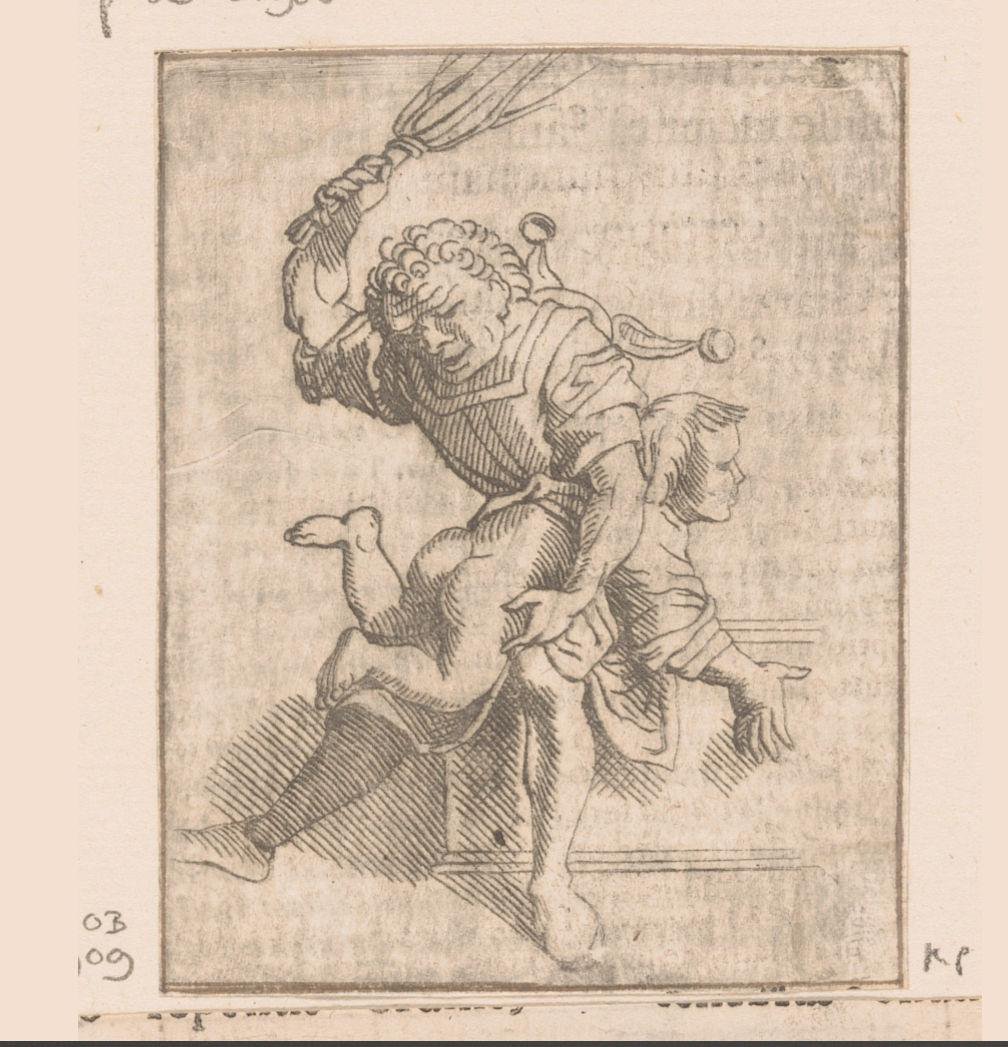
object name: book illustration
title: Onderwijzer straft een leerling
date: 1516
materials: paper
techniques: etching, letterpress printing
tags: rod, birch ~ punishment at school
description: Prent afkomstig uit: Erasmus, Desiderius. Morias enkomion (...). Bazel: Johann Rudolf Genath, 1676. De prenten hierin zijn naar tekeningen die Hans en Ambrosius Holbein maakten voor de theoloog Oswald Myconius in diens uitgave van de Moriae encomium (Lof der Zotheid) van 1516.